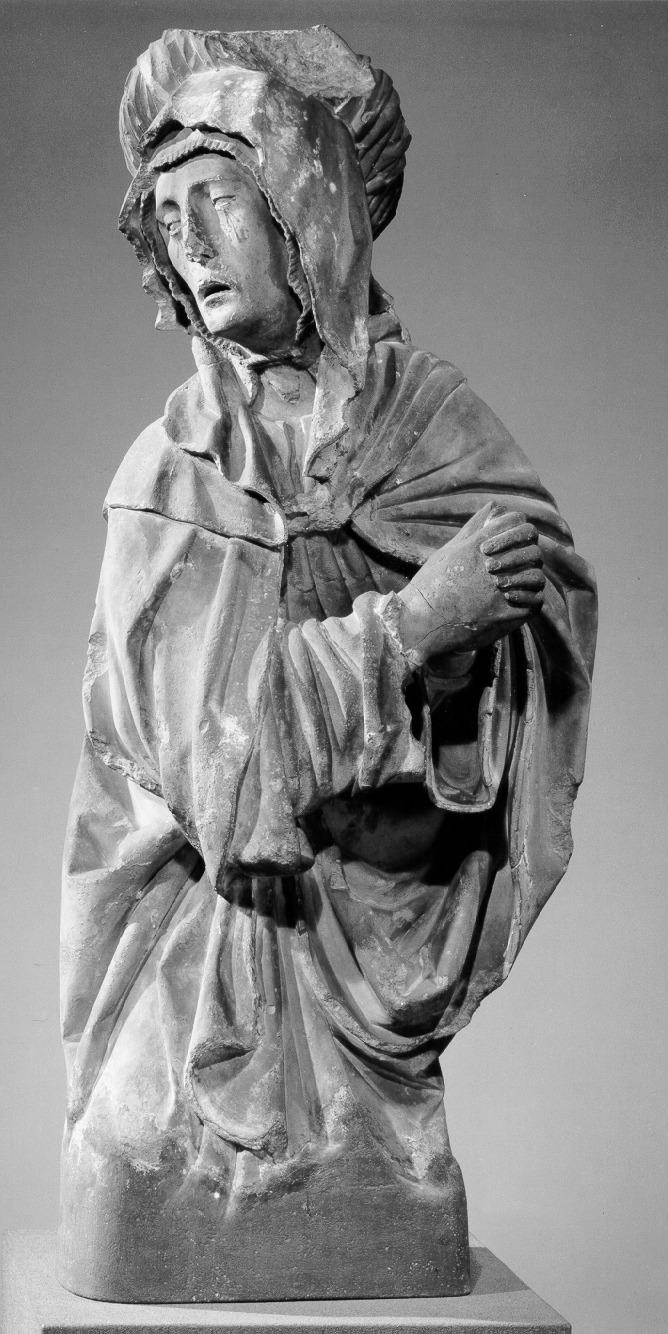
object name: sculpture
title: Mourning Woman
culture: french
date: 1501-1600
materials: paint, stone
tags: sadness,women